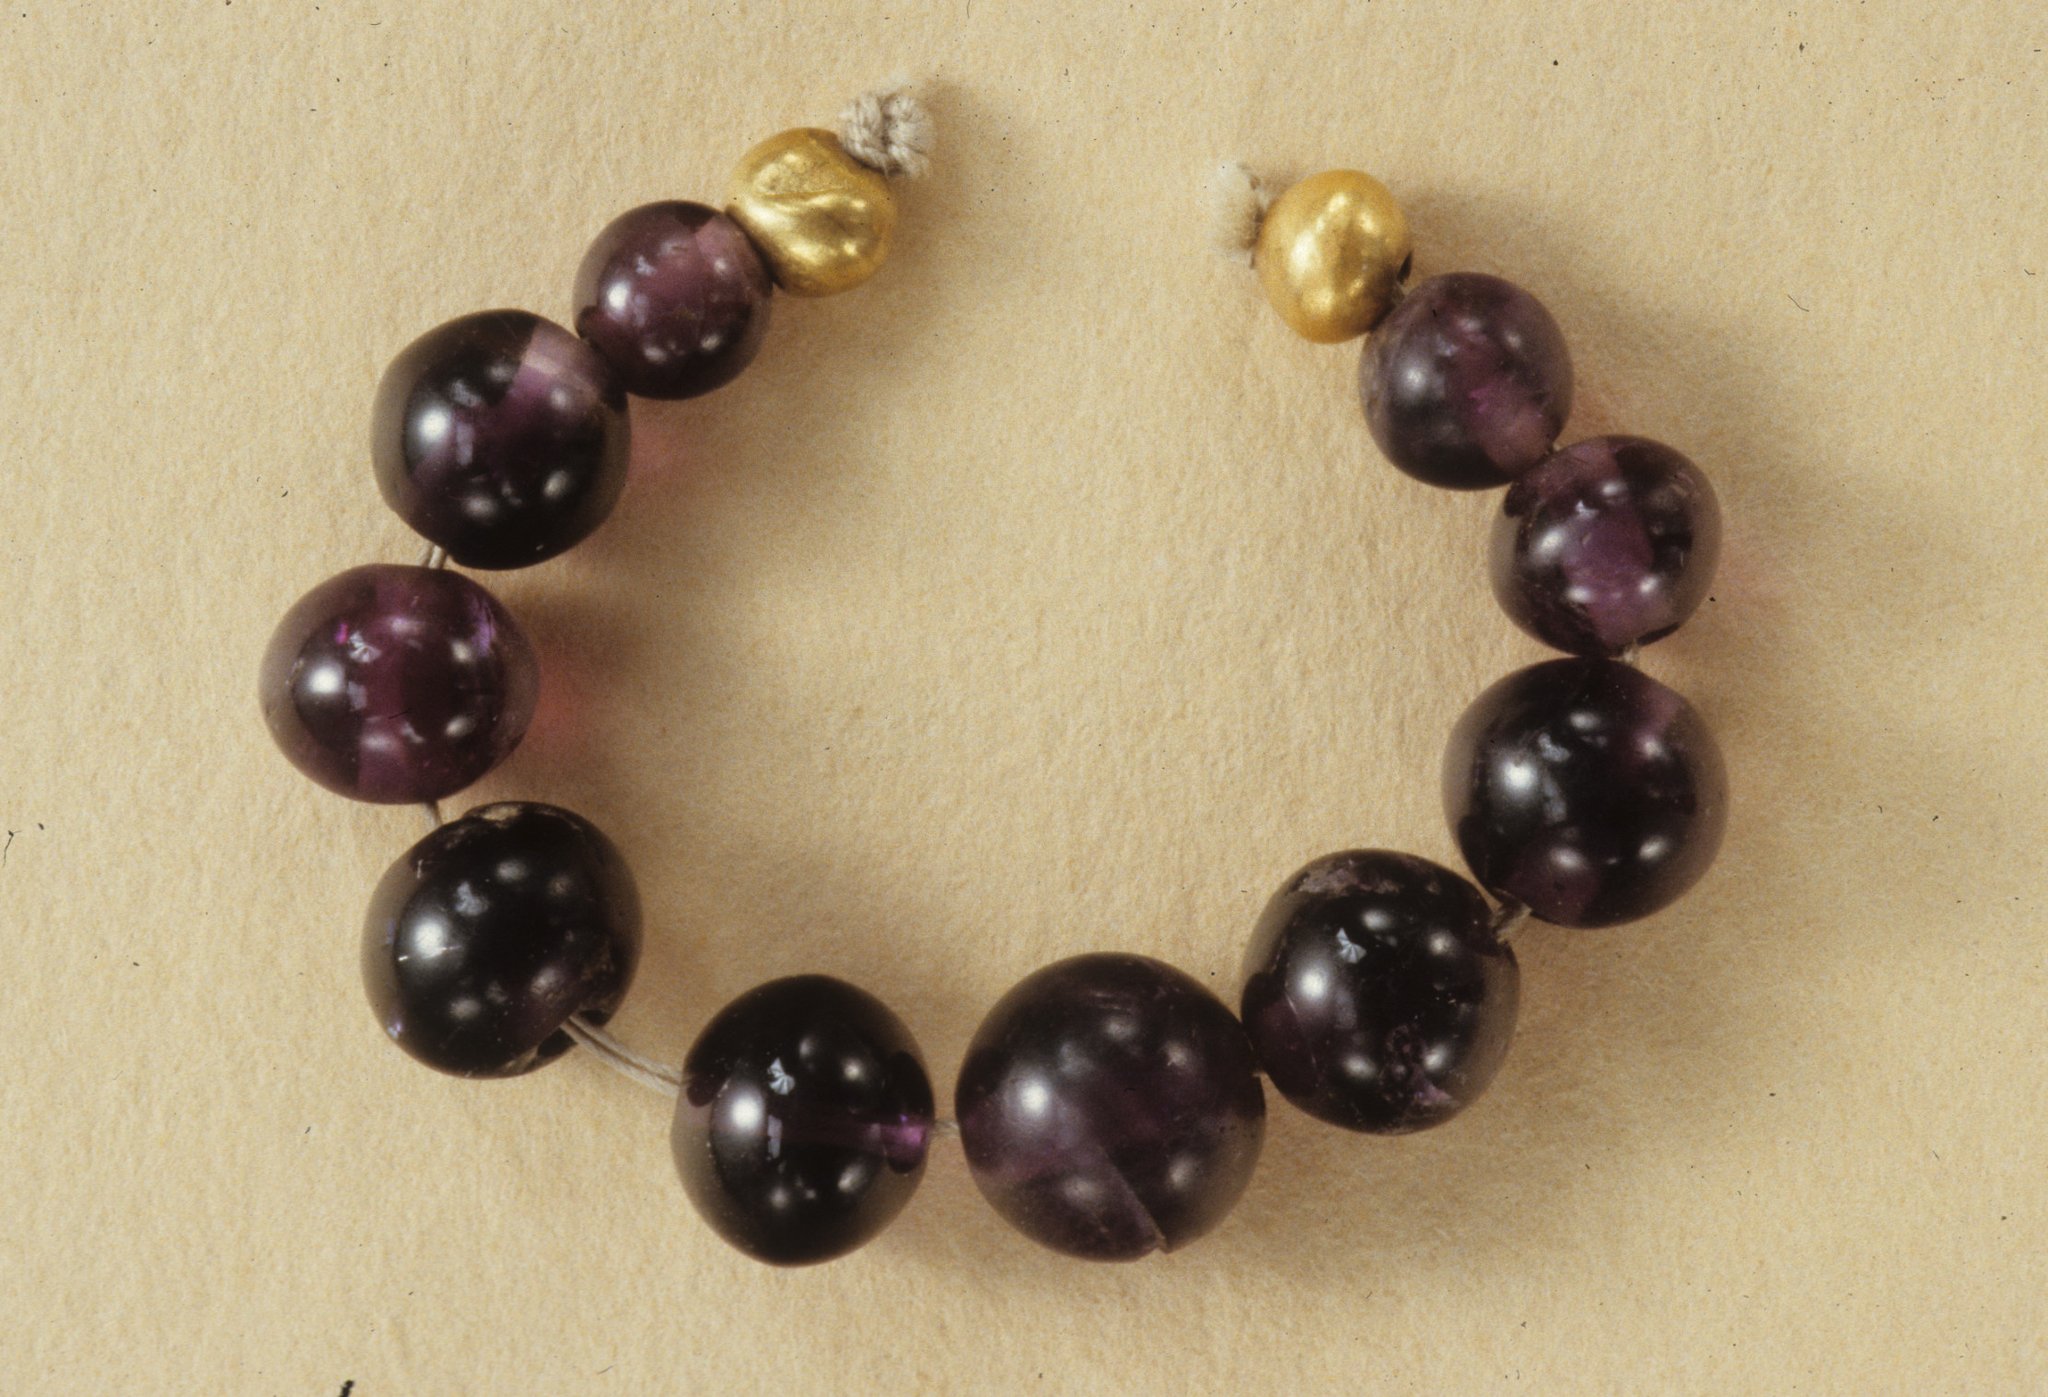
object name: bead, string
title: String of beads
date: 1878-1840 BCE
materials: gemstone, gold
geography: memphite region